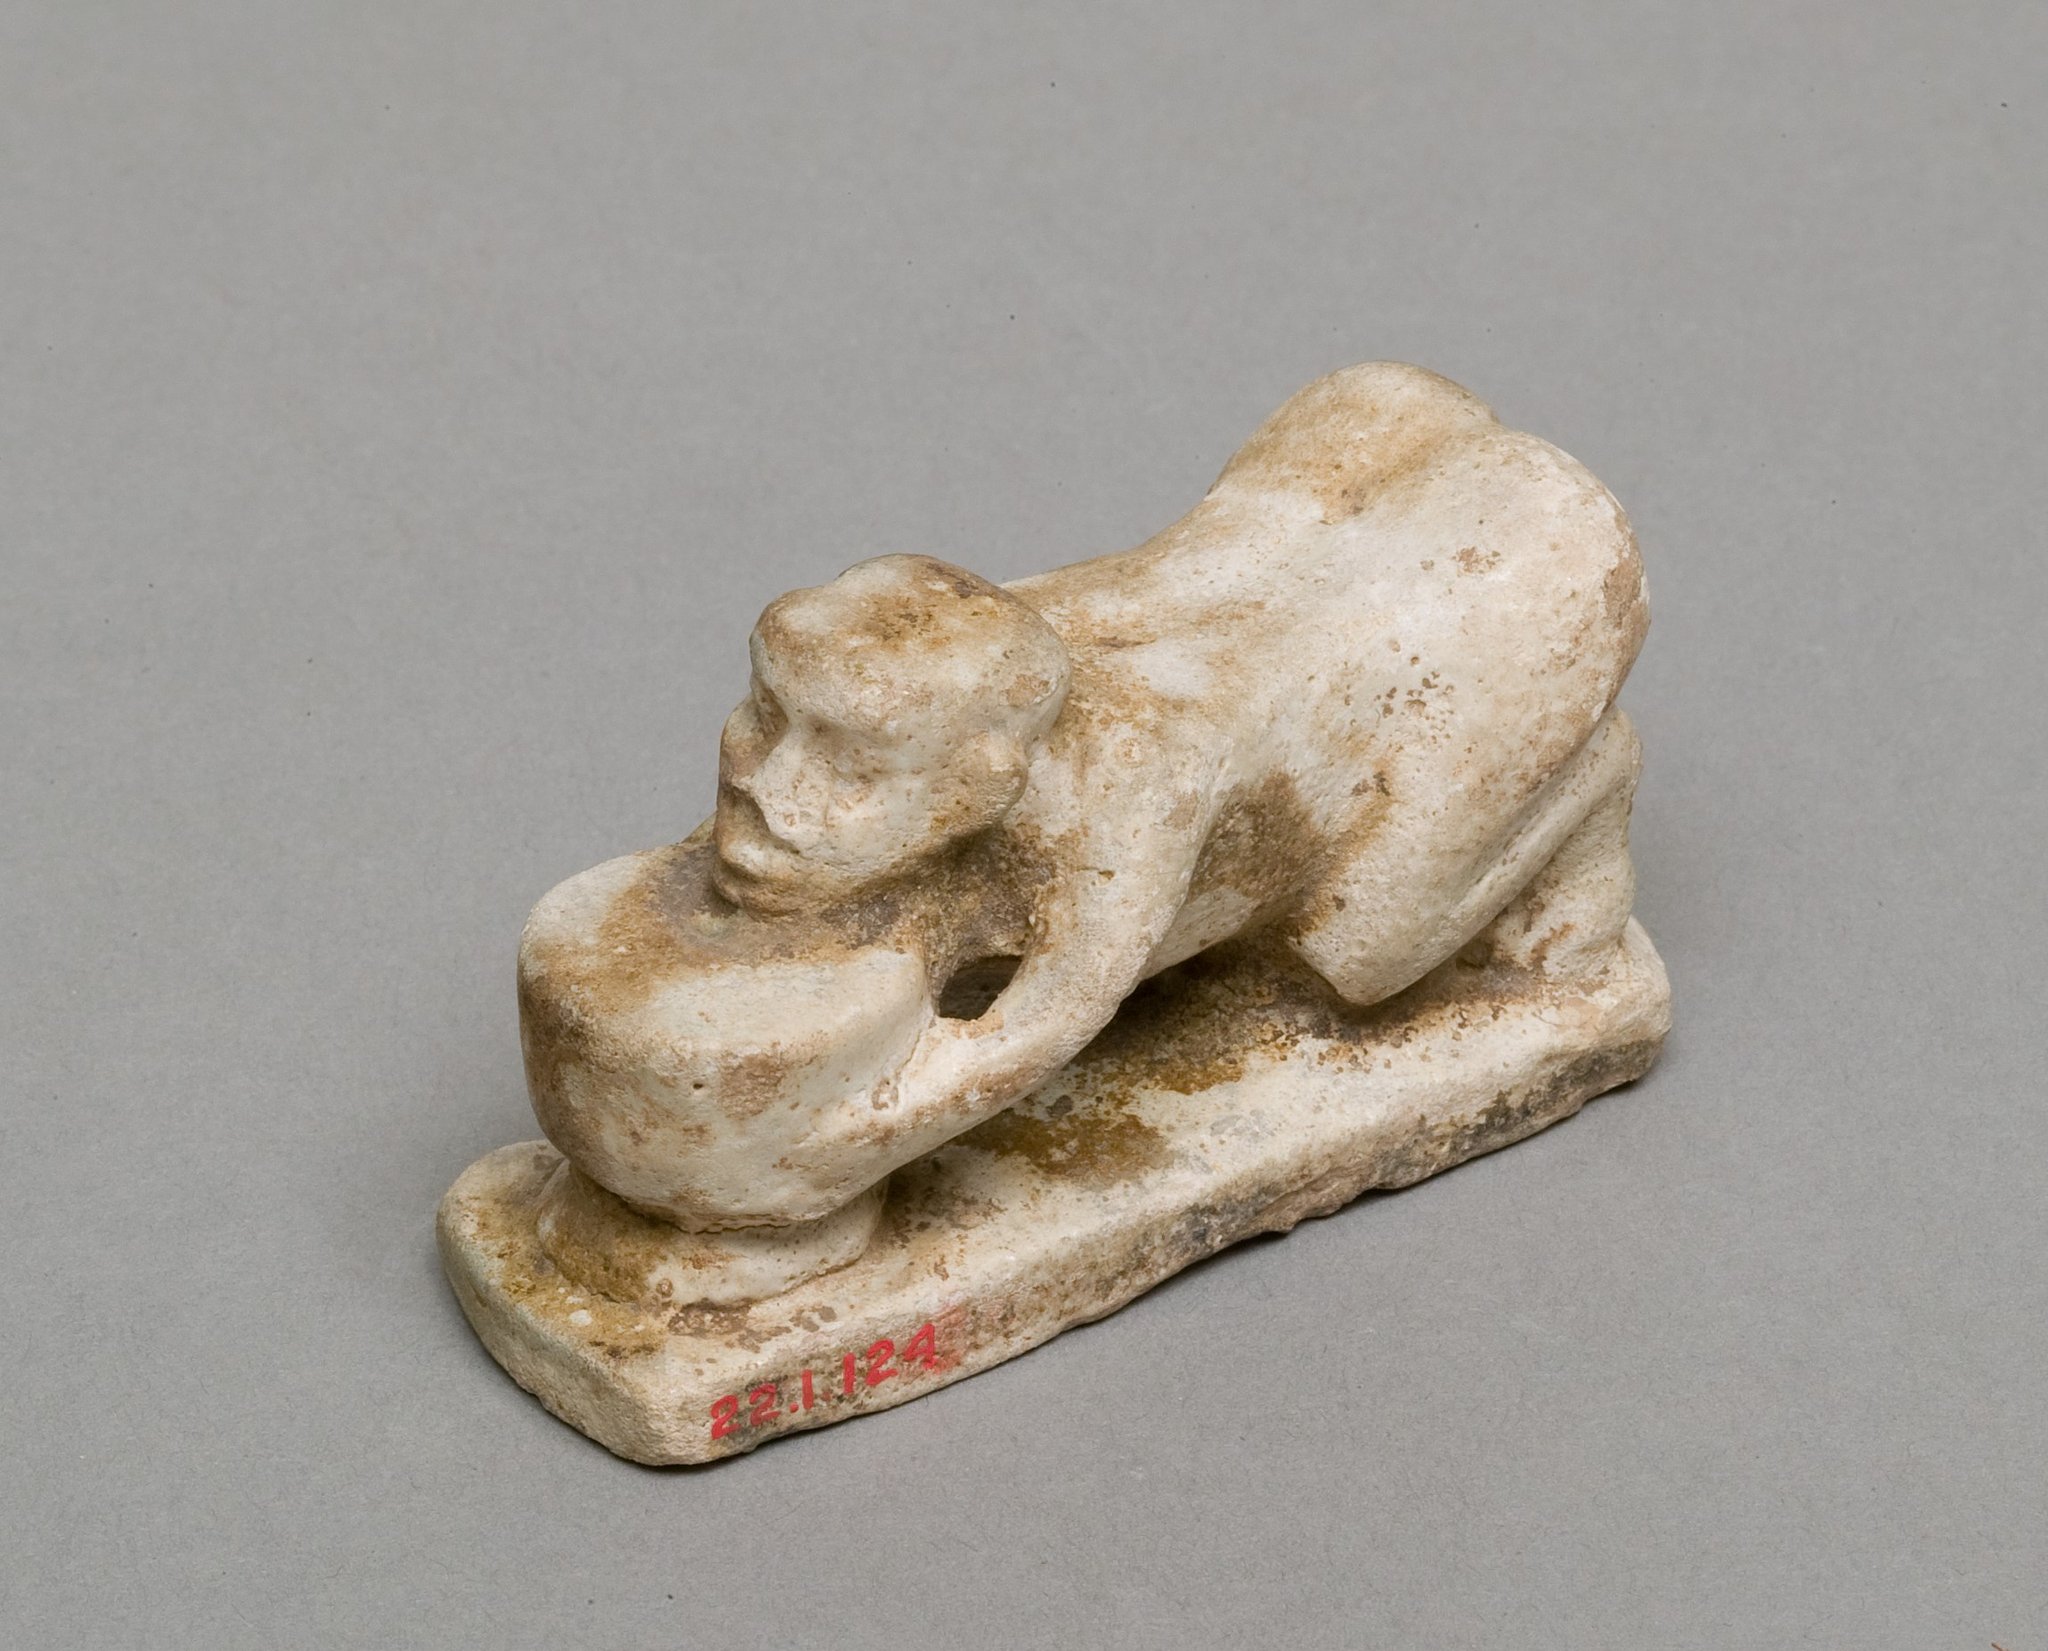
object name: figurine, dwarf with bowl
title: Dwarf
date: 1850-1700 BCE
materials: faience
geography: egypt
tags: men